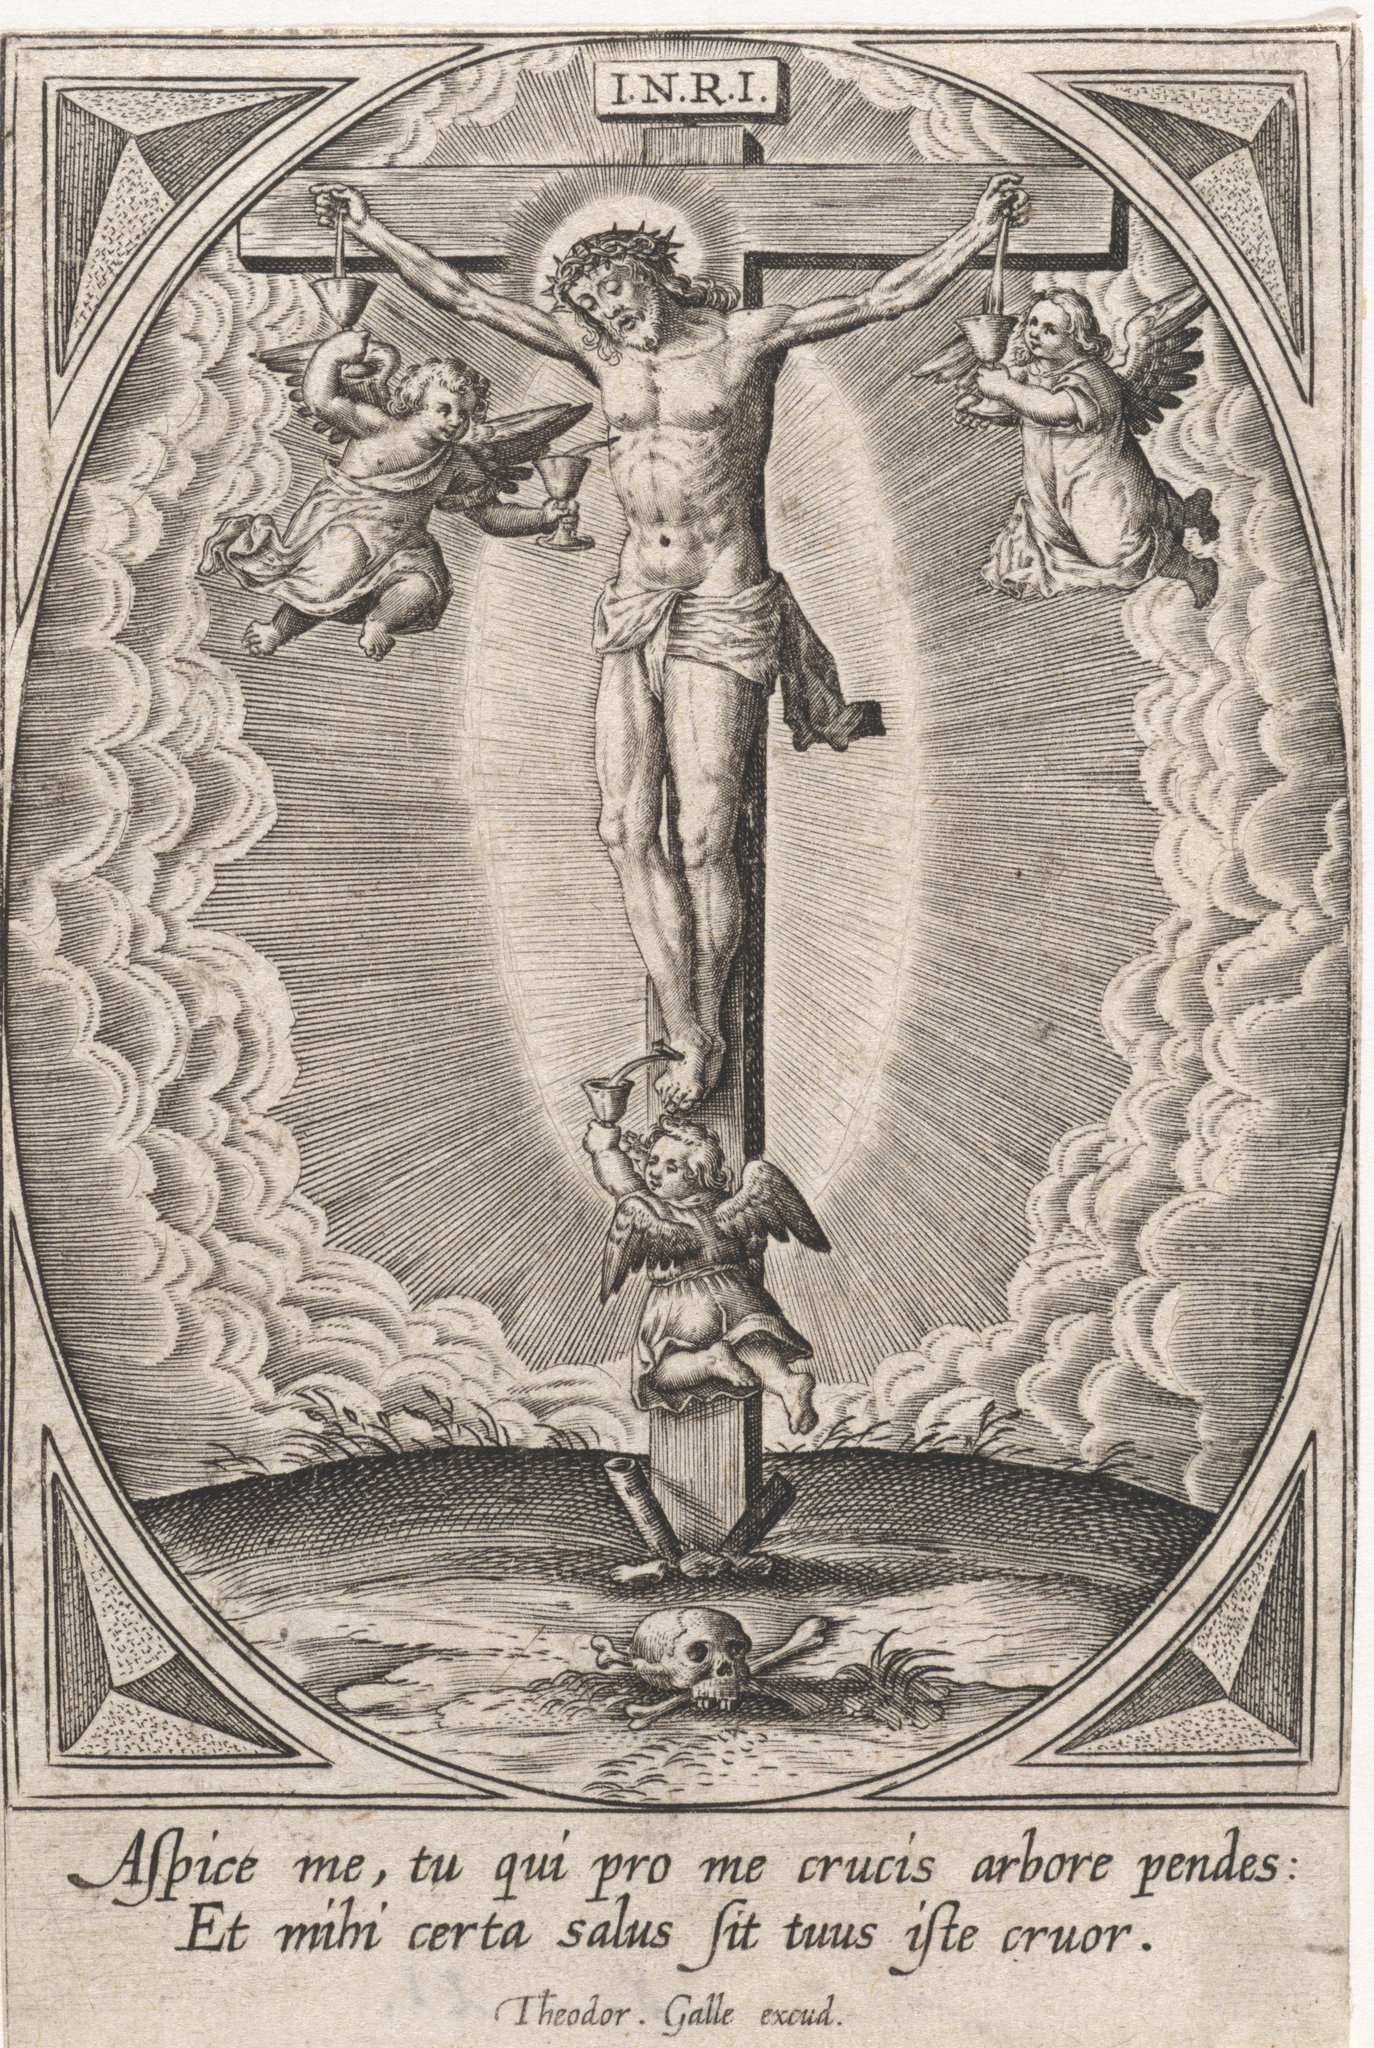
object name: print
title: Kruisiging van Christus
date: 1595-1633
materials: paper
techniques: engraving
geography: antwerp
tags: christ on the cross on golgotha (alone, without bystanders), angel(s) catching christ's blood in cup(s)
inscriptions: number: ‘38 - 21’, collector's mark: Lugt 240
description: Christus hangt aan het kruis. Engelen vangen het bloed uit de wonden van Christus op in hun kelk. In de marge een tweeregelig onderschrift in het Latijn.